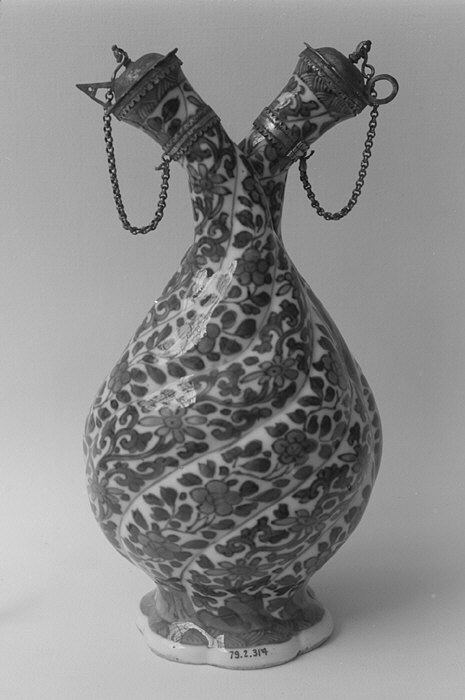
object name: cruet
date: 1700-1710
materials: gilt copper, hard paste porcelain